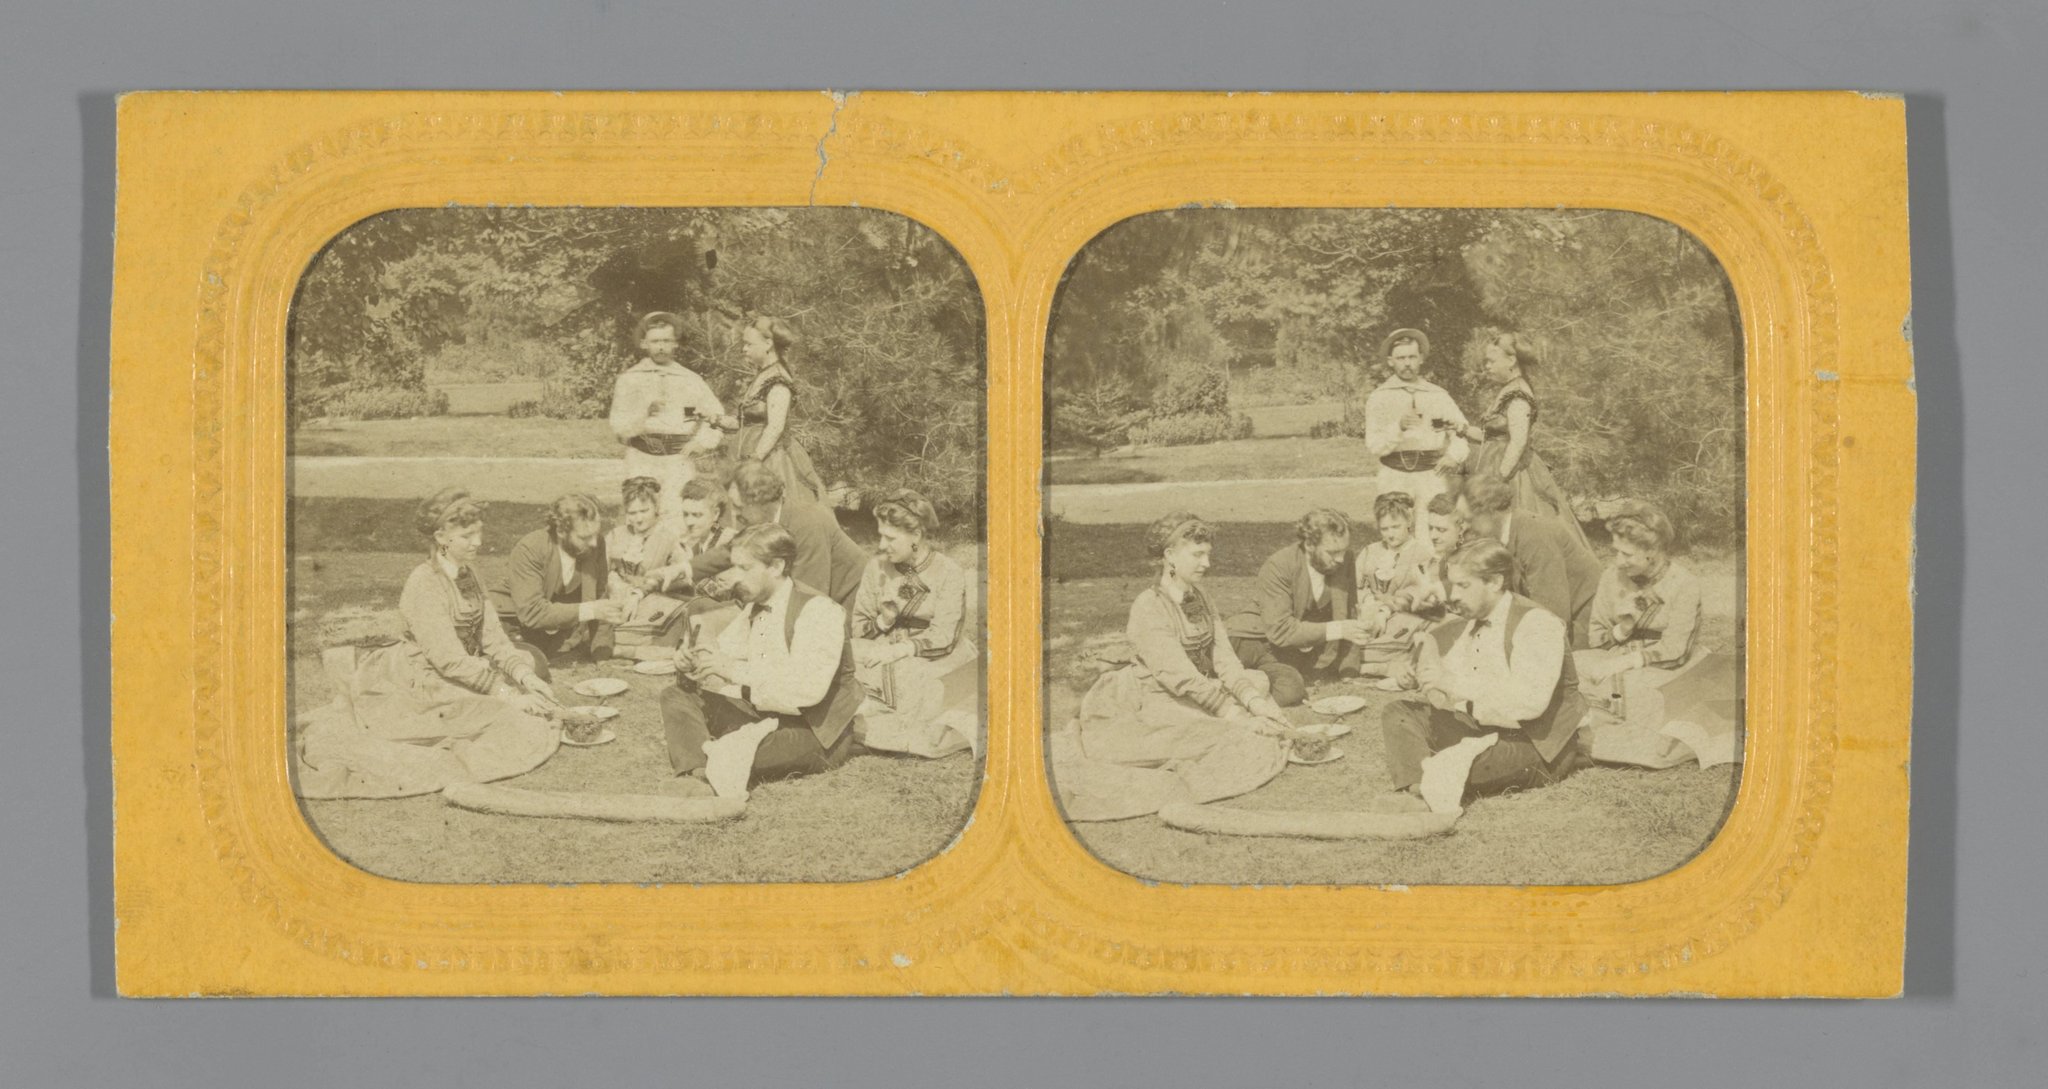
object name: tissue stereograph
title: Gezelschap tijdens picnick in bos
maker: Anonymous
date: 1855-1875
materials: cardboard, paper, photographic support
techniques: albumen print, hand coloring, perforating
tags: picnic, alfresco, 'déjeuner sur l'herbe'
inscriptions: number: ‘10’